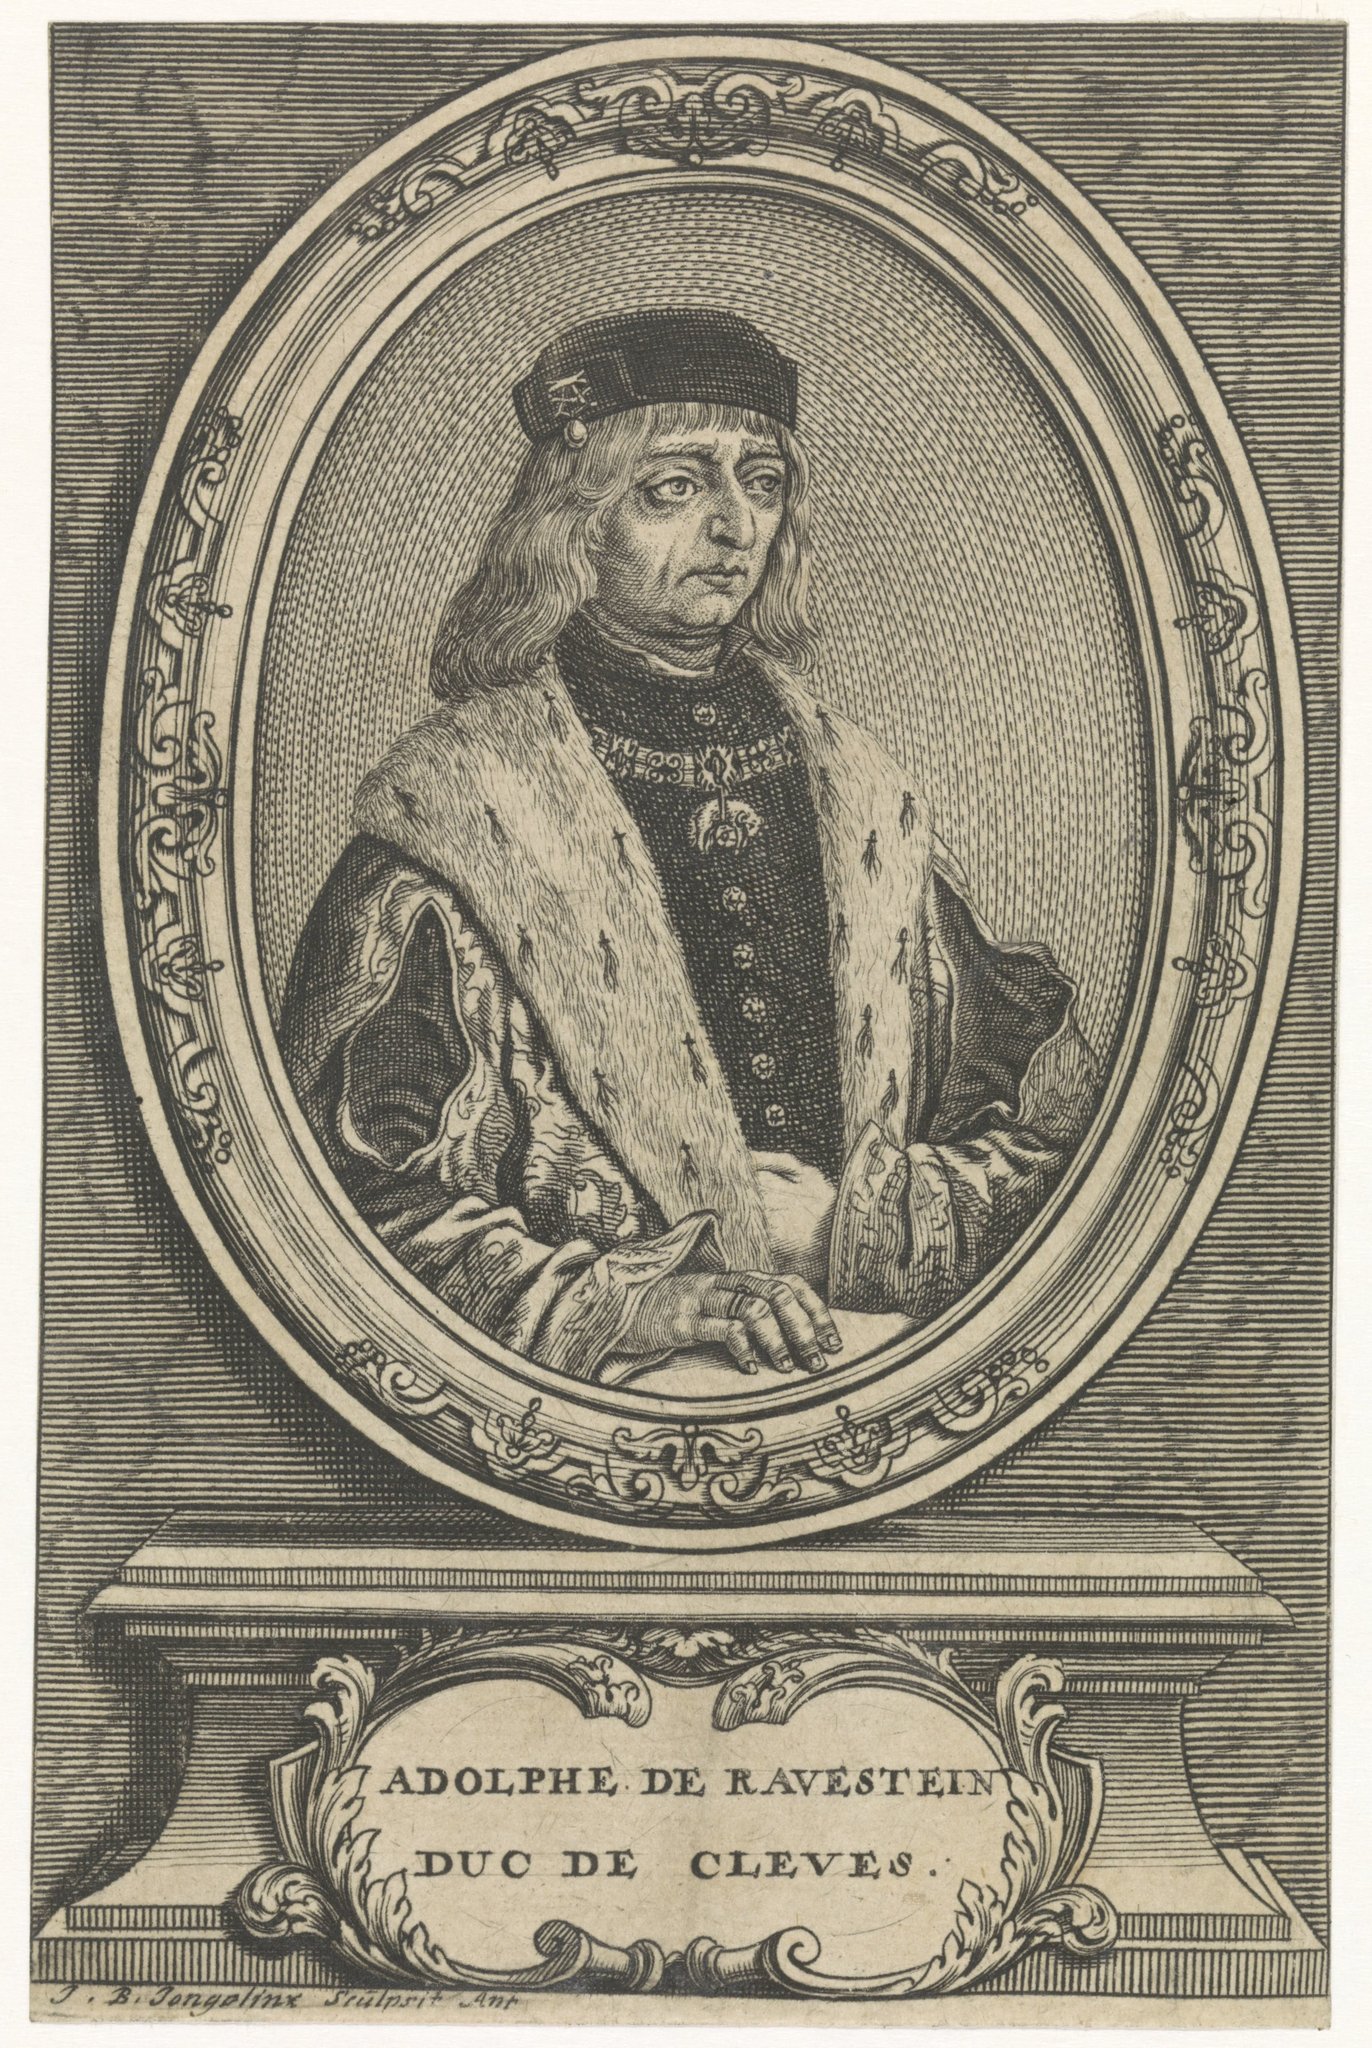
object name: print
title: Portret van Adolf van Kleef, heer van Ravestein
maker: jan baptist jongelinx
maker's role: print maker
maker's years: 1689-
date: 1710-1725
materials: paper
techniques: engraving, etching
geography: antwerp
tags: knighthood order of the golden fleece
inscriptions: collector's mark: Lugt 2228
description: Busteportret van Adolf van Kleef, met baret. Hij draagt een keten met de Orde van het Gulden Vlies. Zijn linkerhand heeft hij in zijn mantel gestoken. Het portret is gevat in een ovale omlijsting met decoraties. In een cartouche een tweeregelig onderschrift in het Frans.